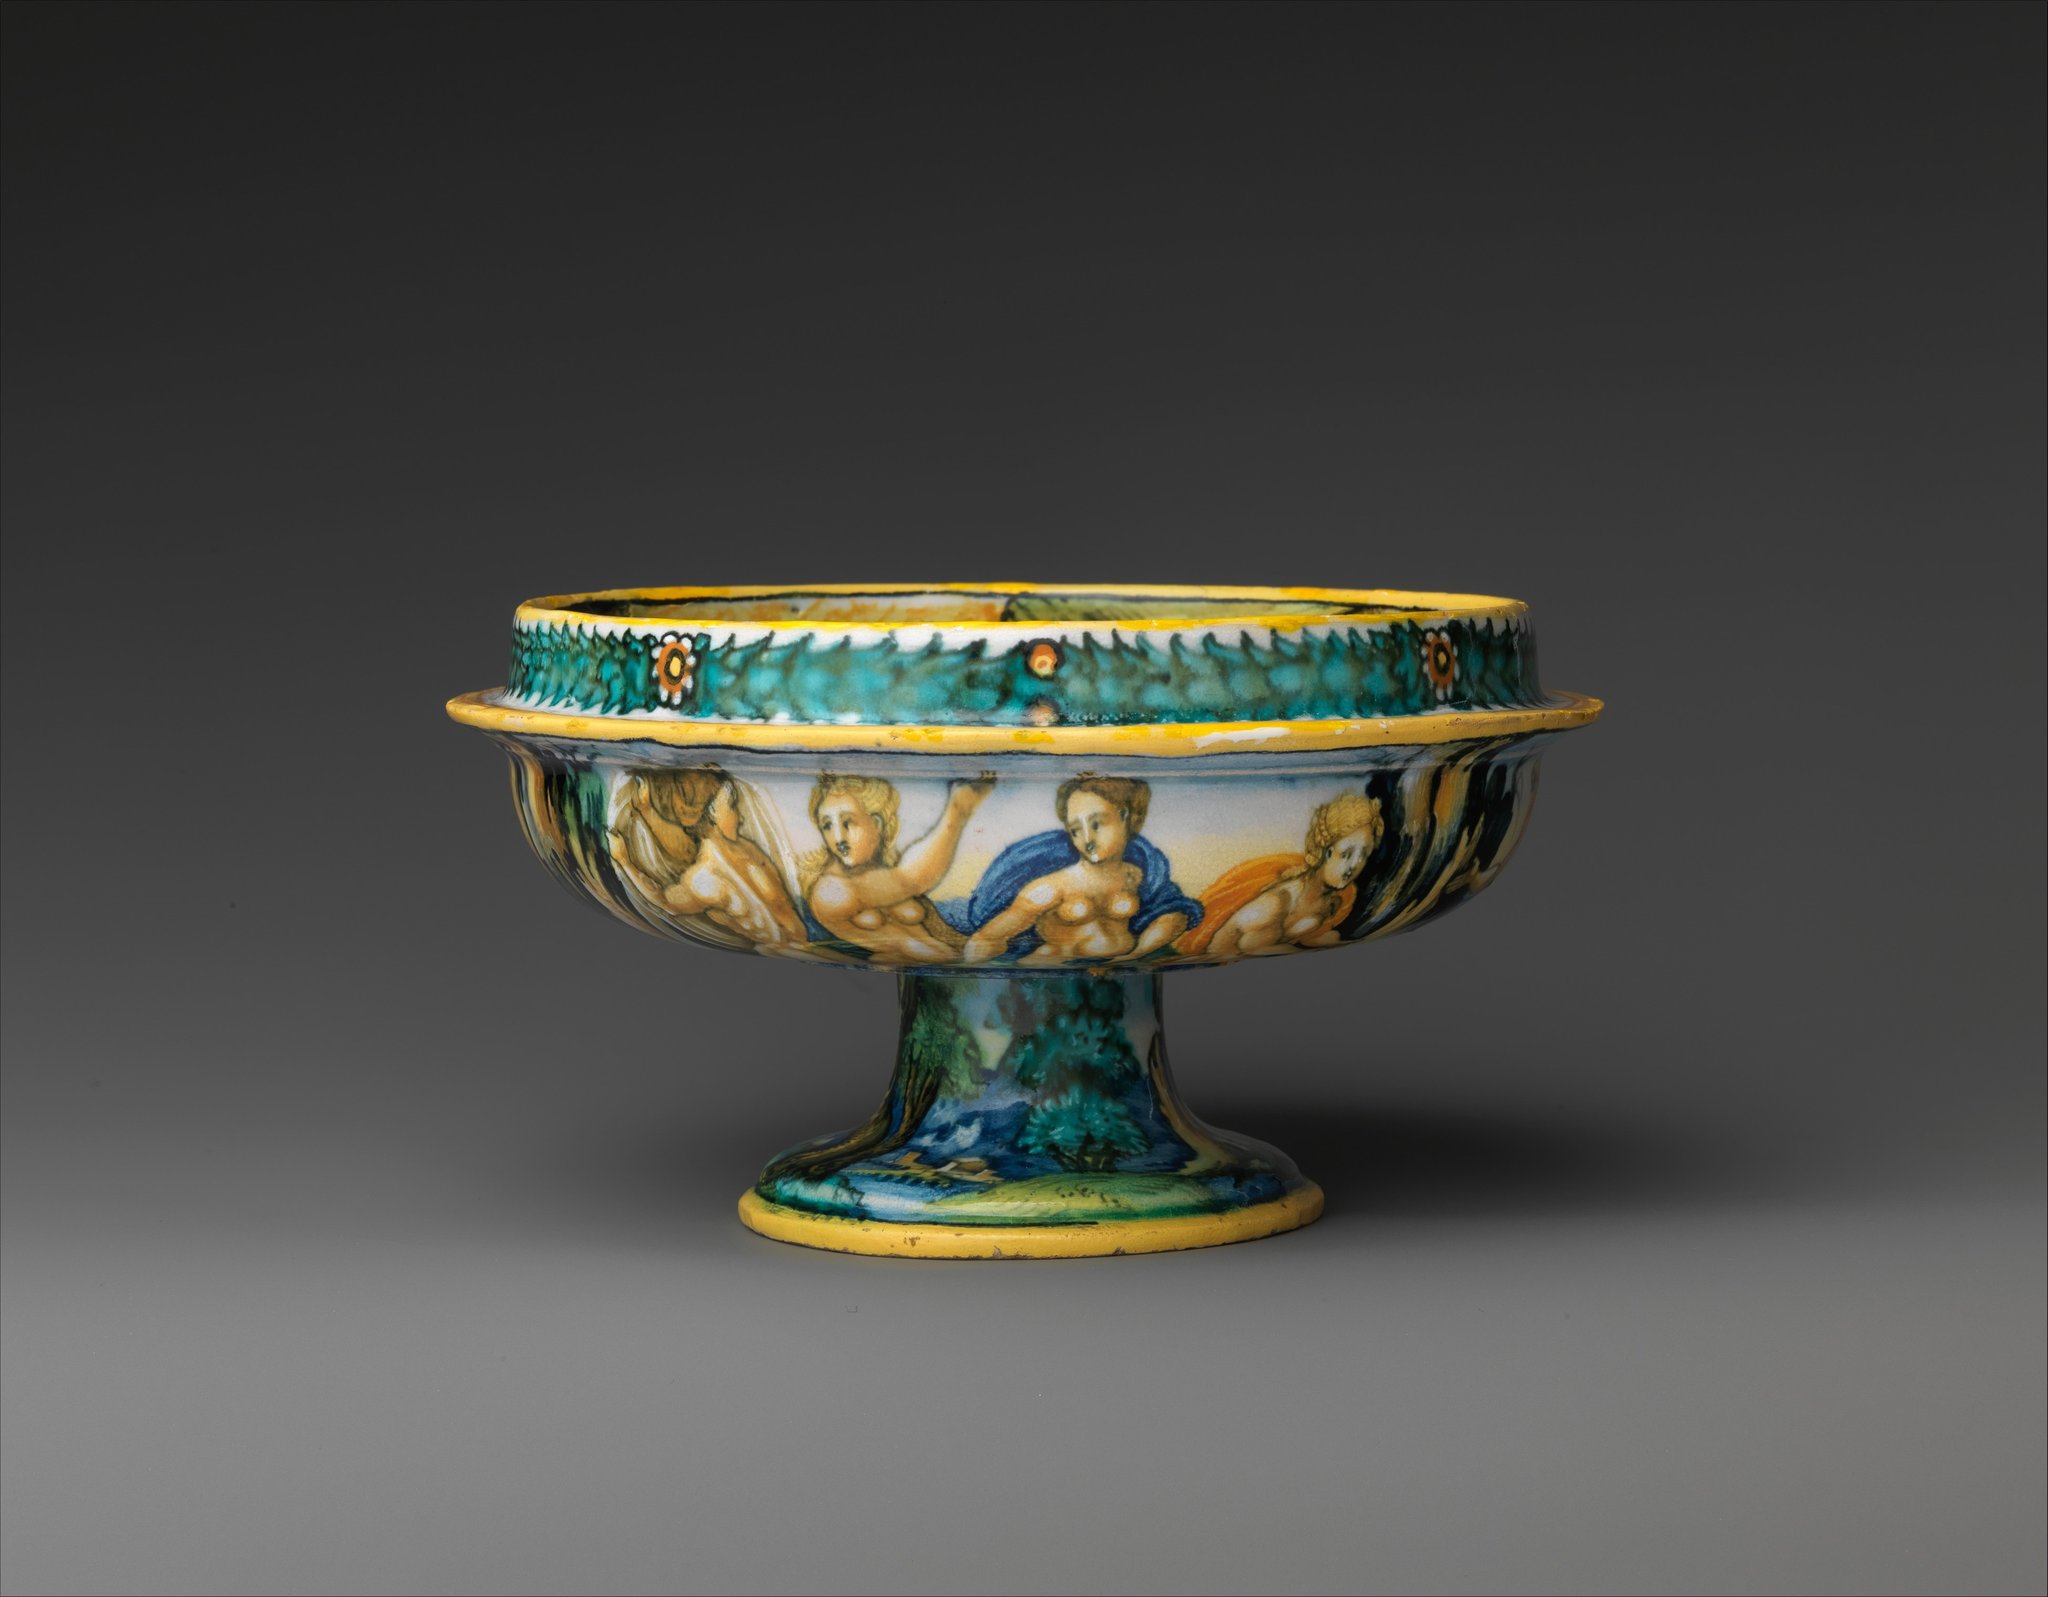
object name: bowl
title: Bowl from a birth set with birth scene and Diana and Actaeon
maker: the "milan marsyas" painter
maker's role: artist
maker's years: 1500-1550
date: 1530-1532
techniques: maiolica, glazing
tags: infants,women,female nudes,actaeon,diana,beds